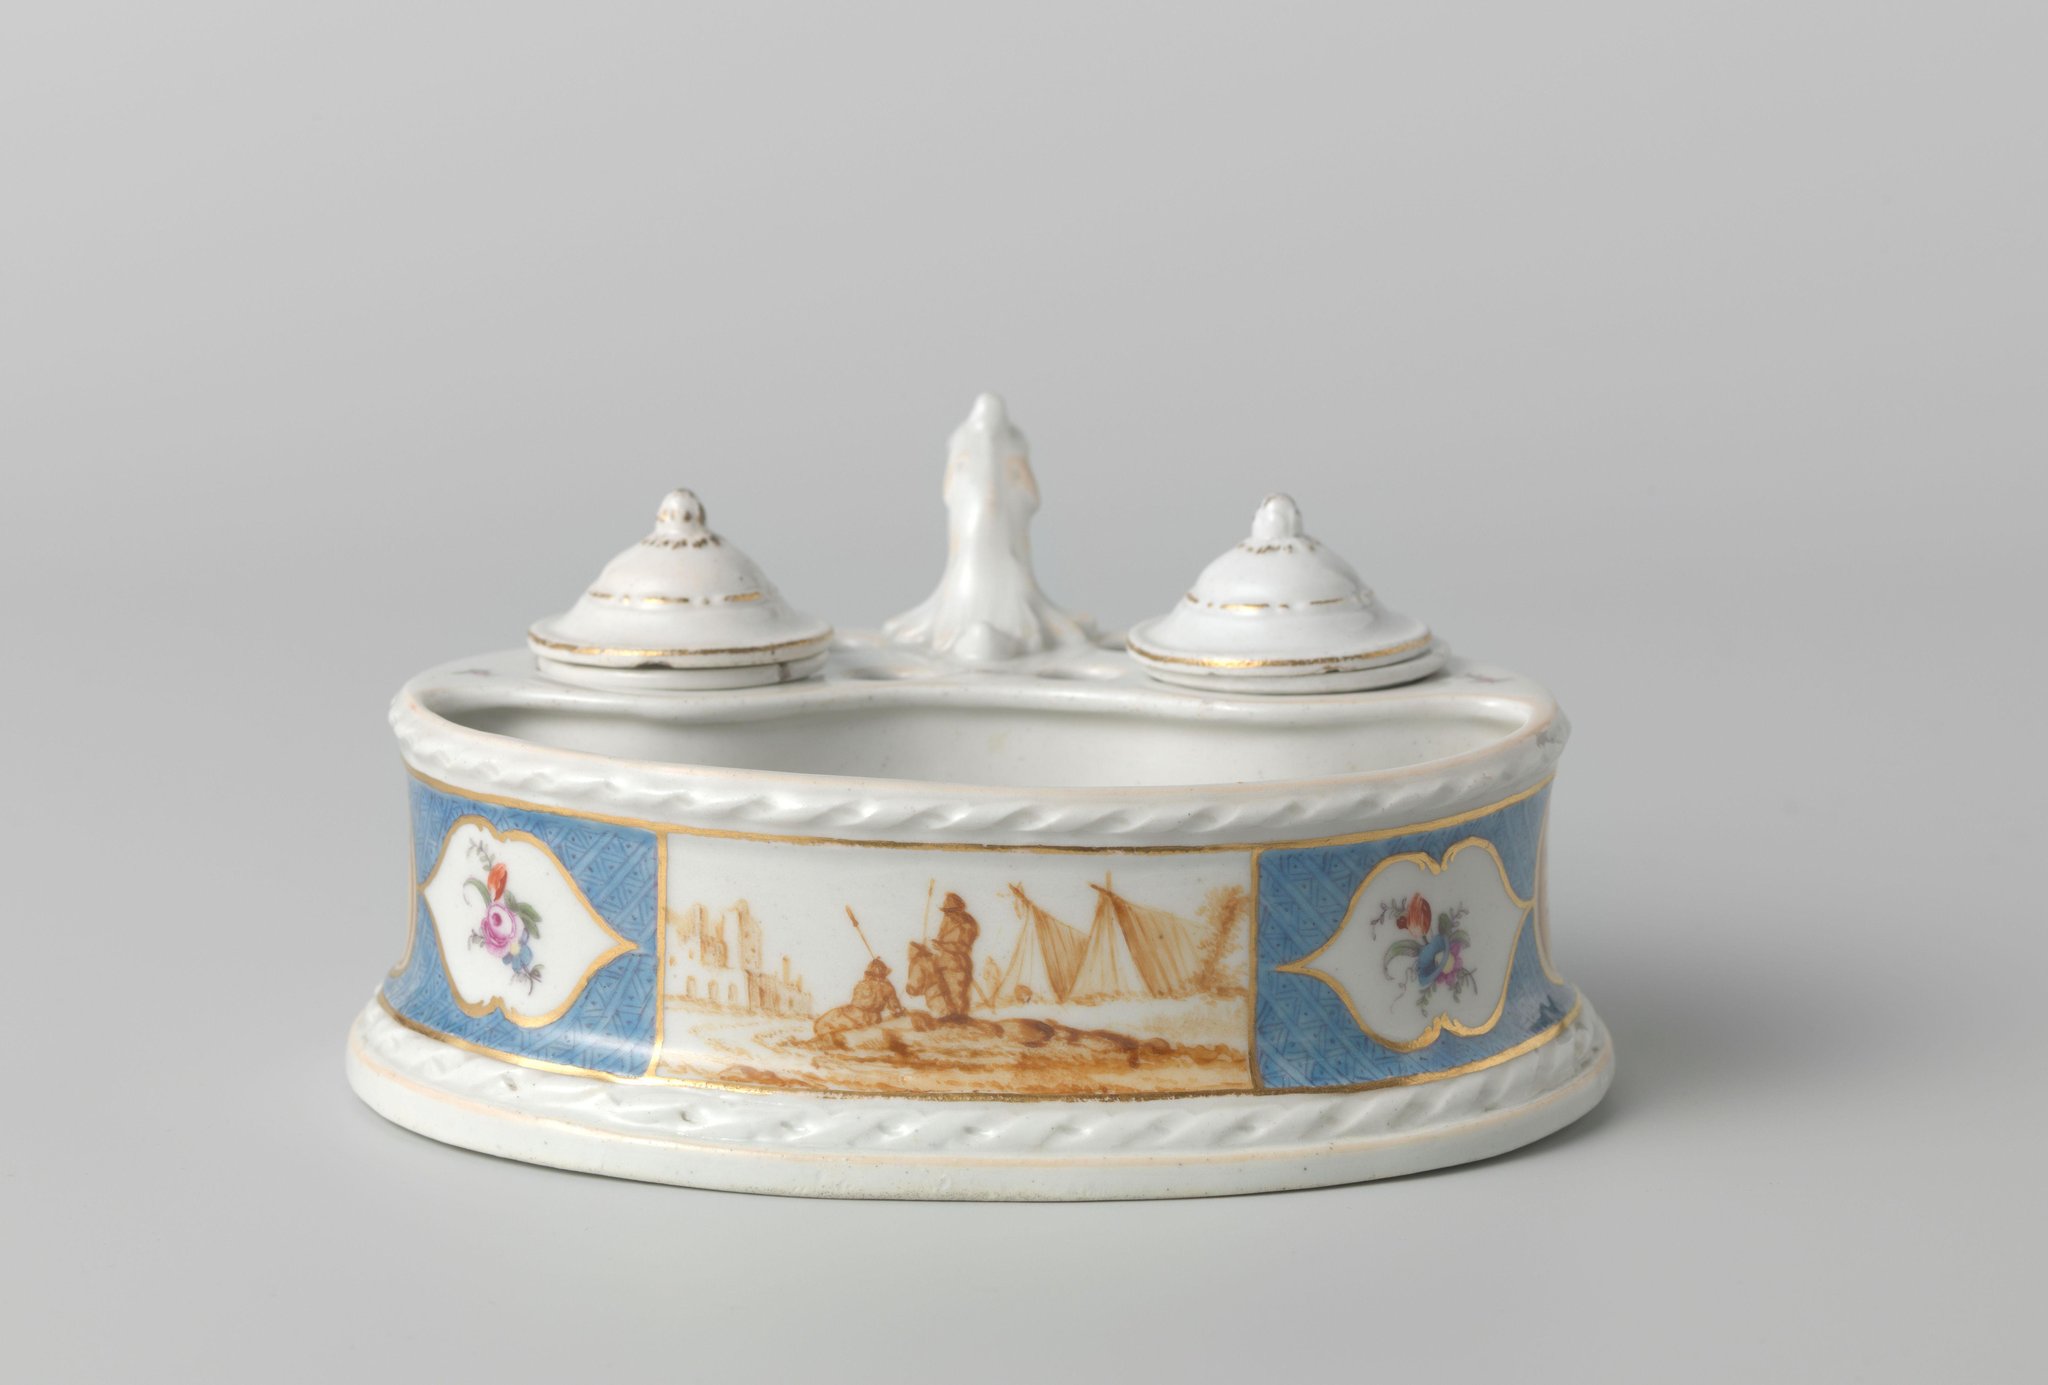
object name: inkwell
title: Inktpot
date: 1778-1782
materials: porcelain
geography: loosdrecht